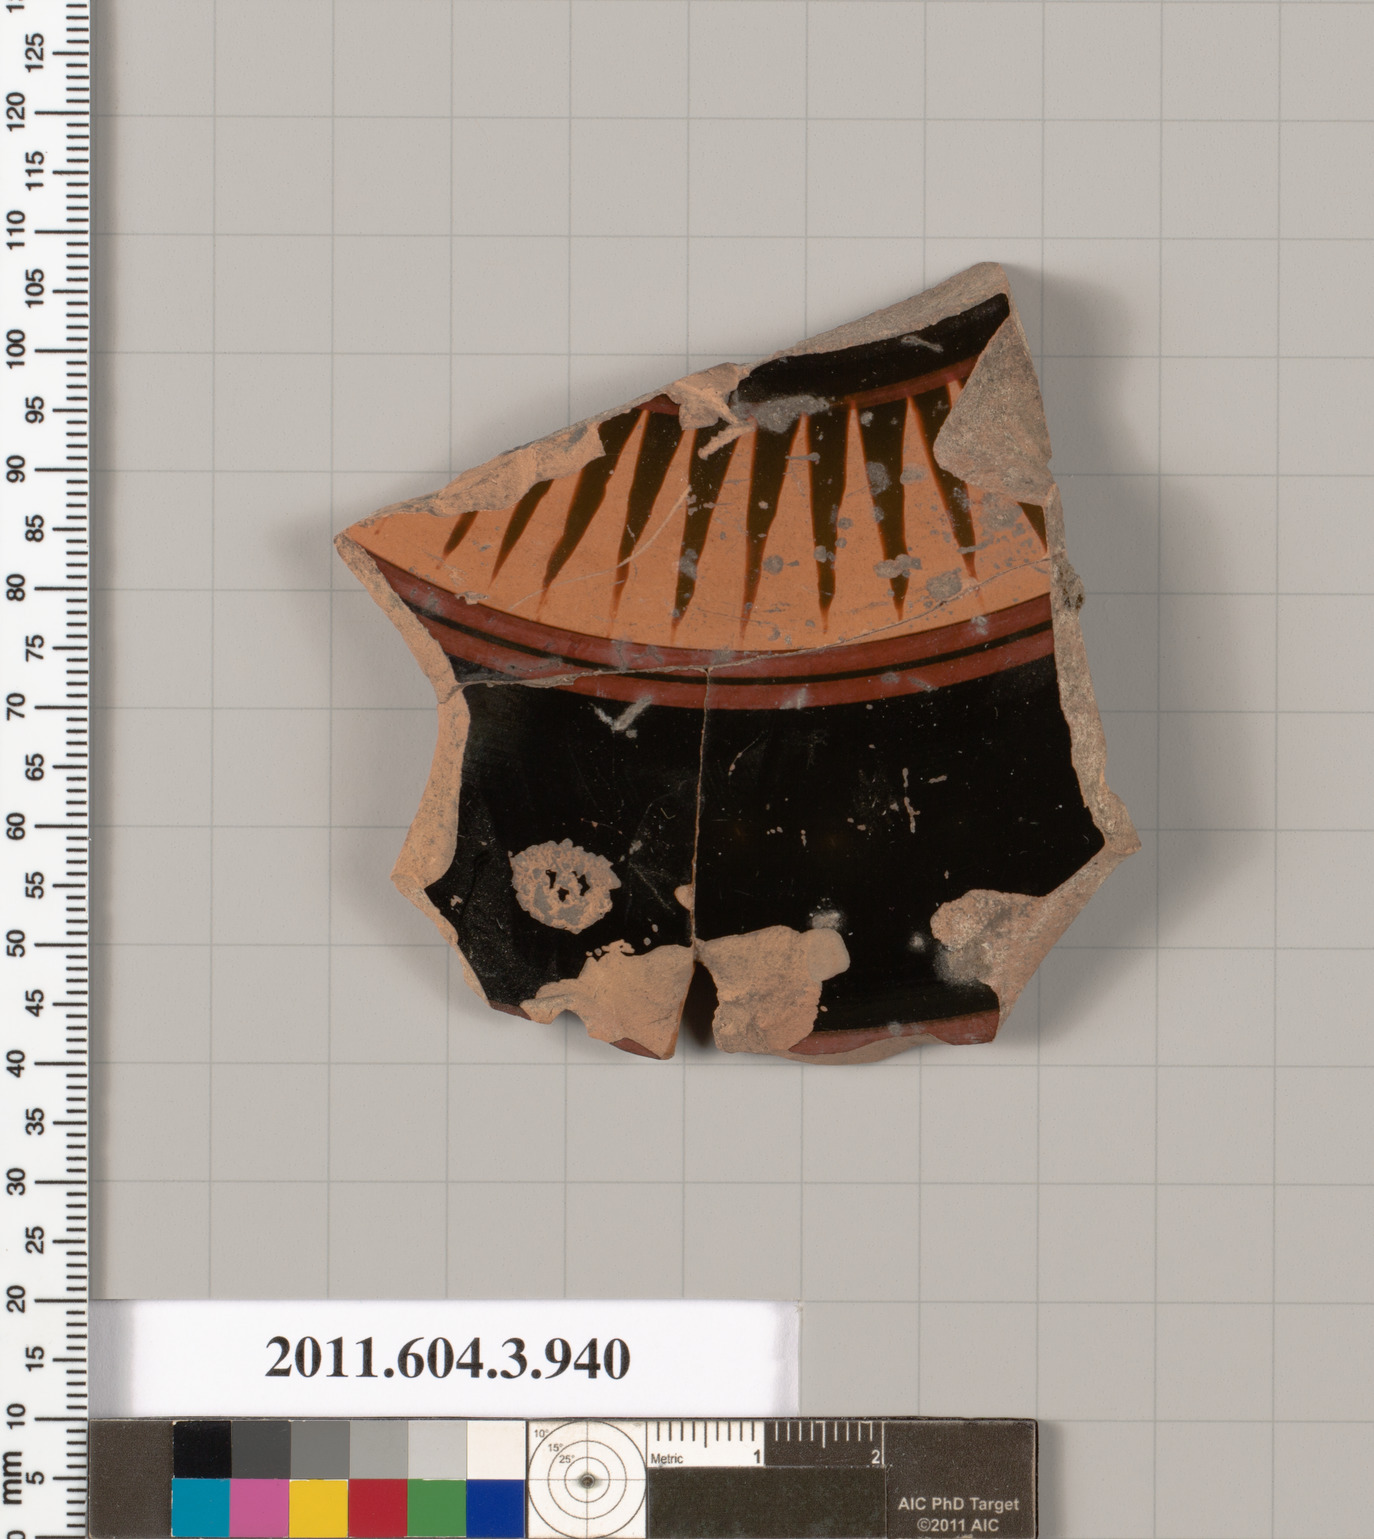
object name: lekanis lid fragment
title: Terracotta fragment of a lekanis lid (covered dish)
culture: greek, attic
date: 600-501 BCE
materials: terracotta